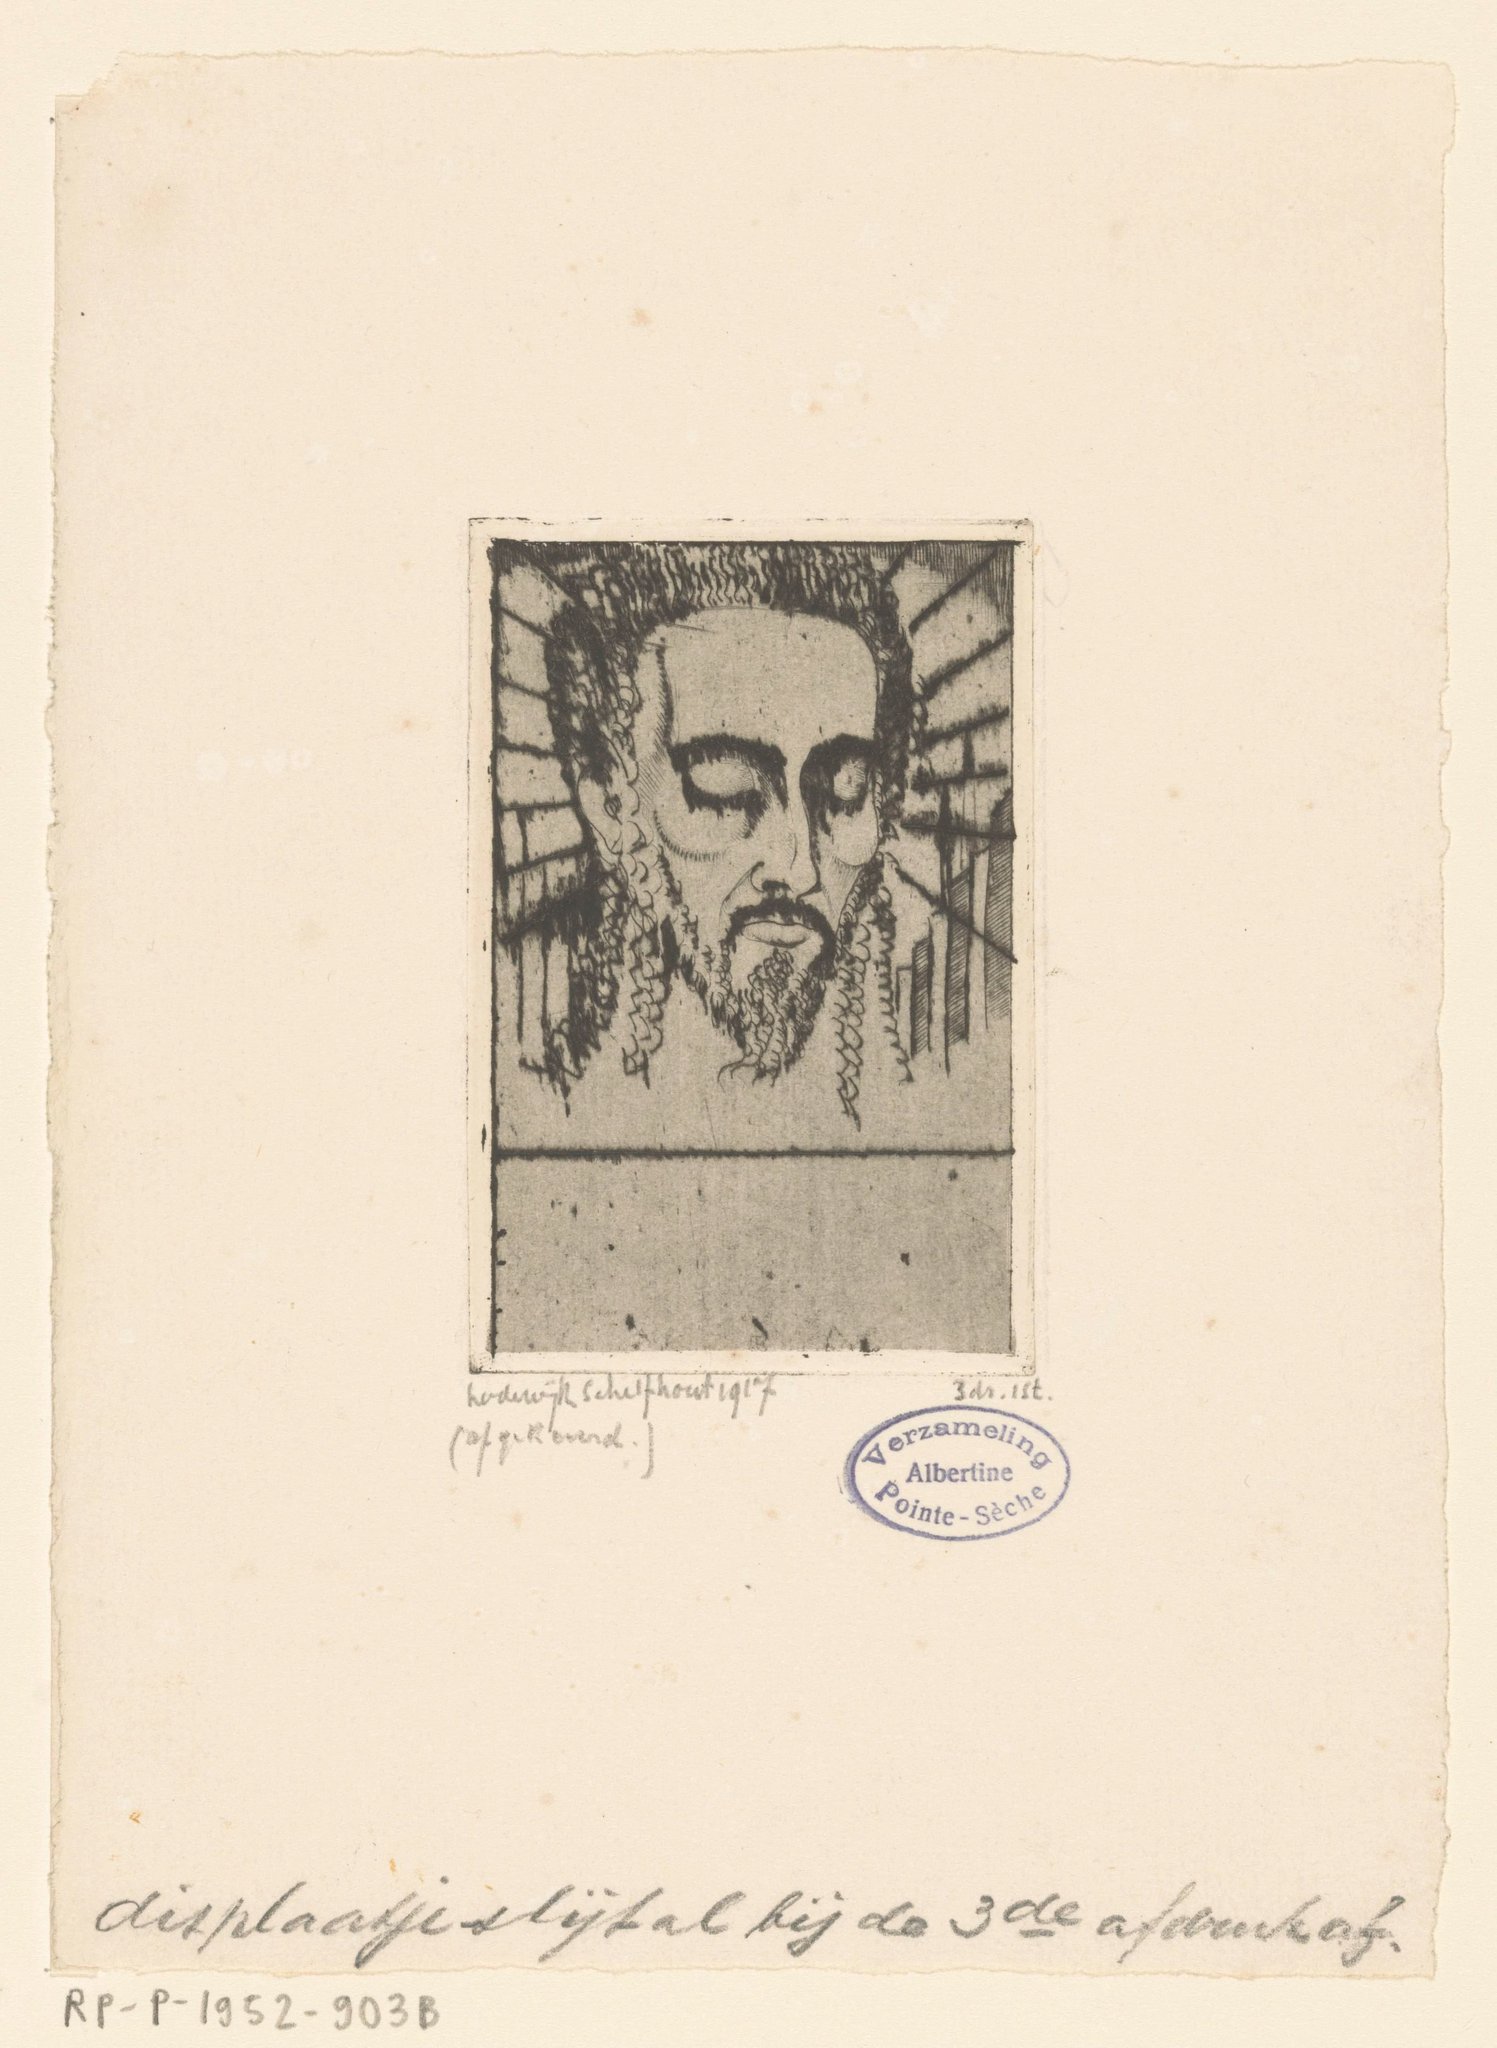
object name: print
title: Tête de Christ III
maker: lodewijk schelfhout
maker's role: draughtsman, print maker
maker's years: 1881-1943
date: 1917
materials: paper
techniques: drypoint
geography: netherlands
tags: rays as nimbus, christ as adult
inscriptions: collector's mark: Lugt 2760, collector's mark: Lugt 2228, collector's mark: Lugt 5i, inscription: ‘afger[....] / dit plaatje slijt al bij de 3de afdruk af’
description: Het hoofd van Christus, omgeven door lichtstralen.